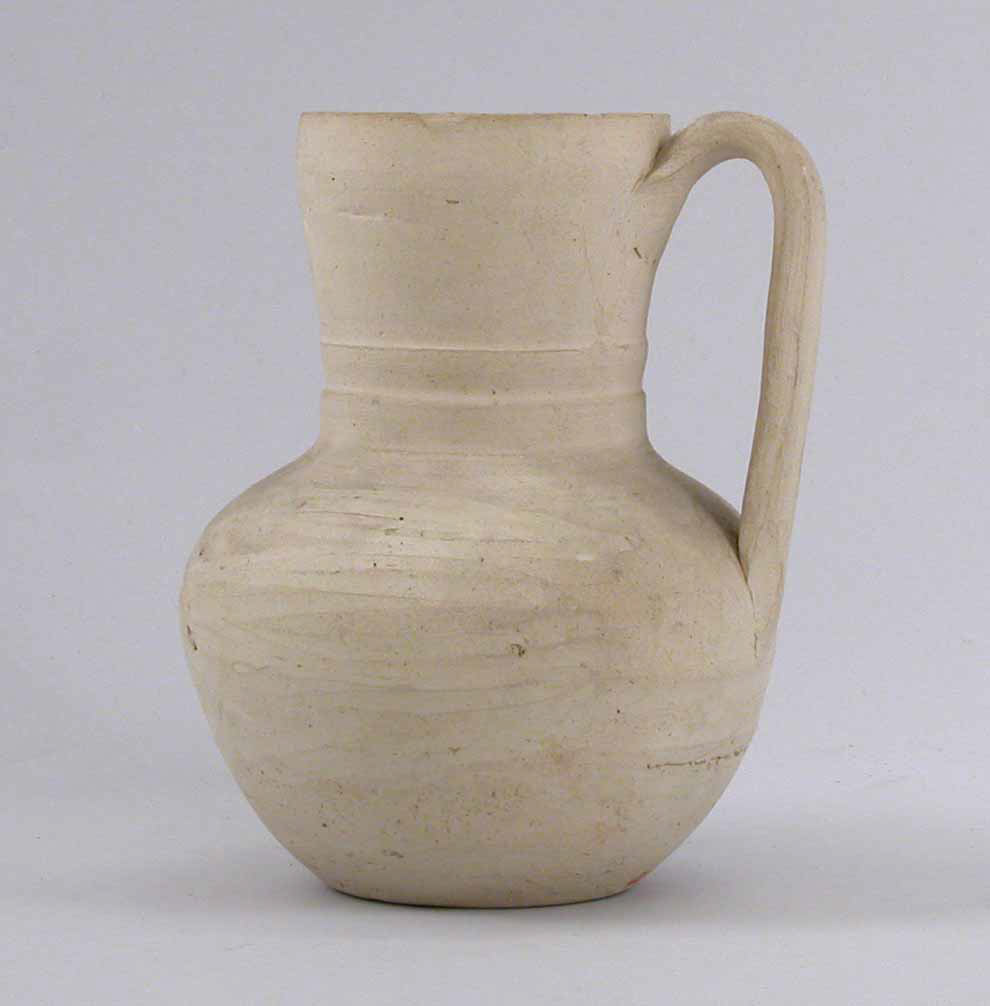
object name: ewer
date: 767-900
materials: earthenware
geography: iran